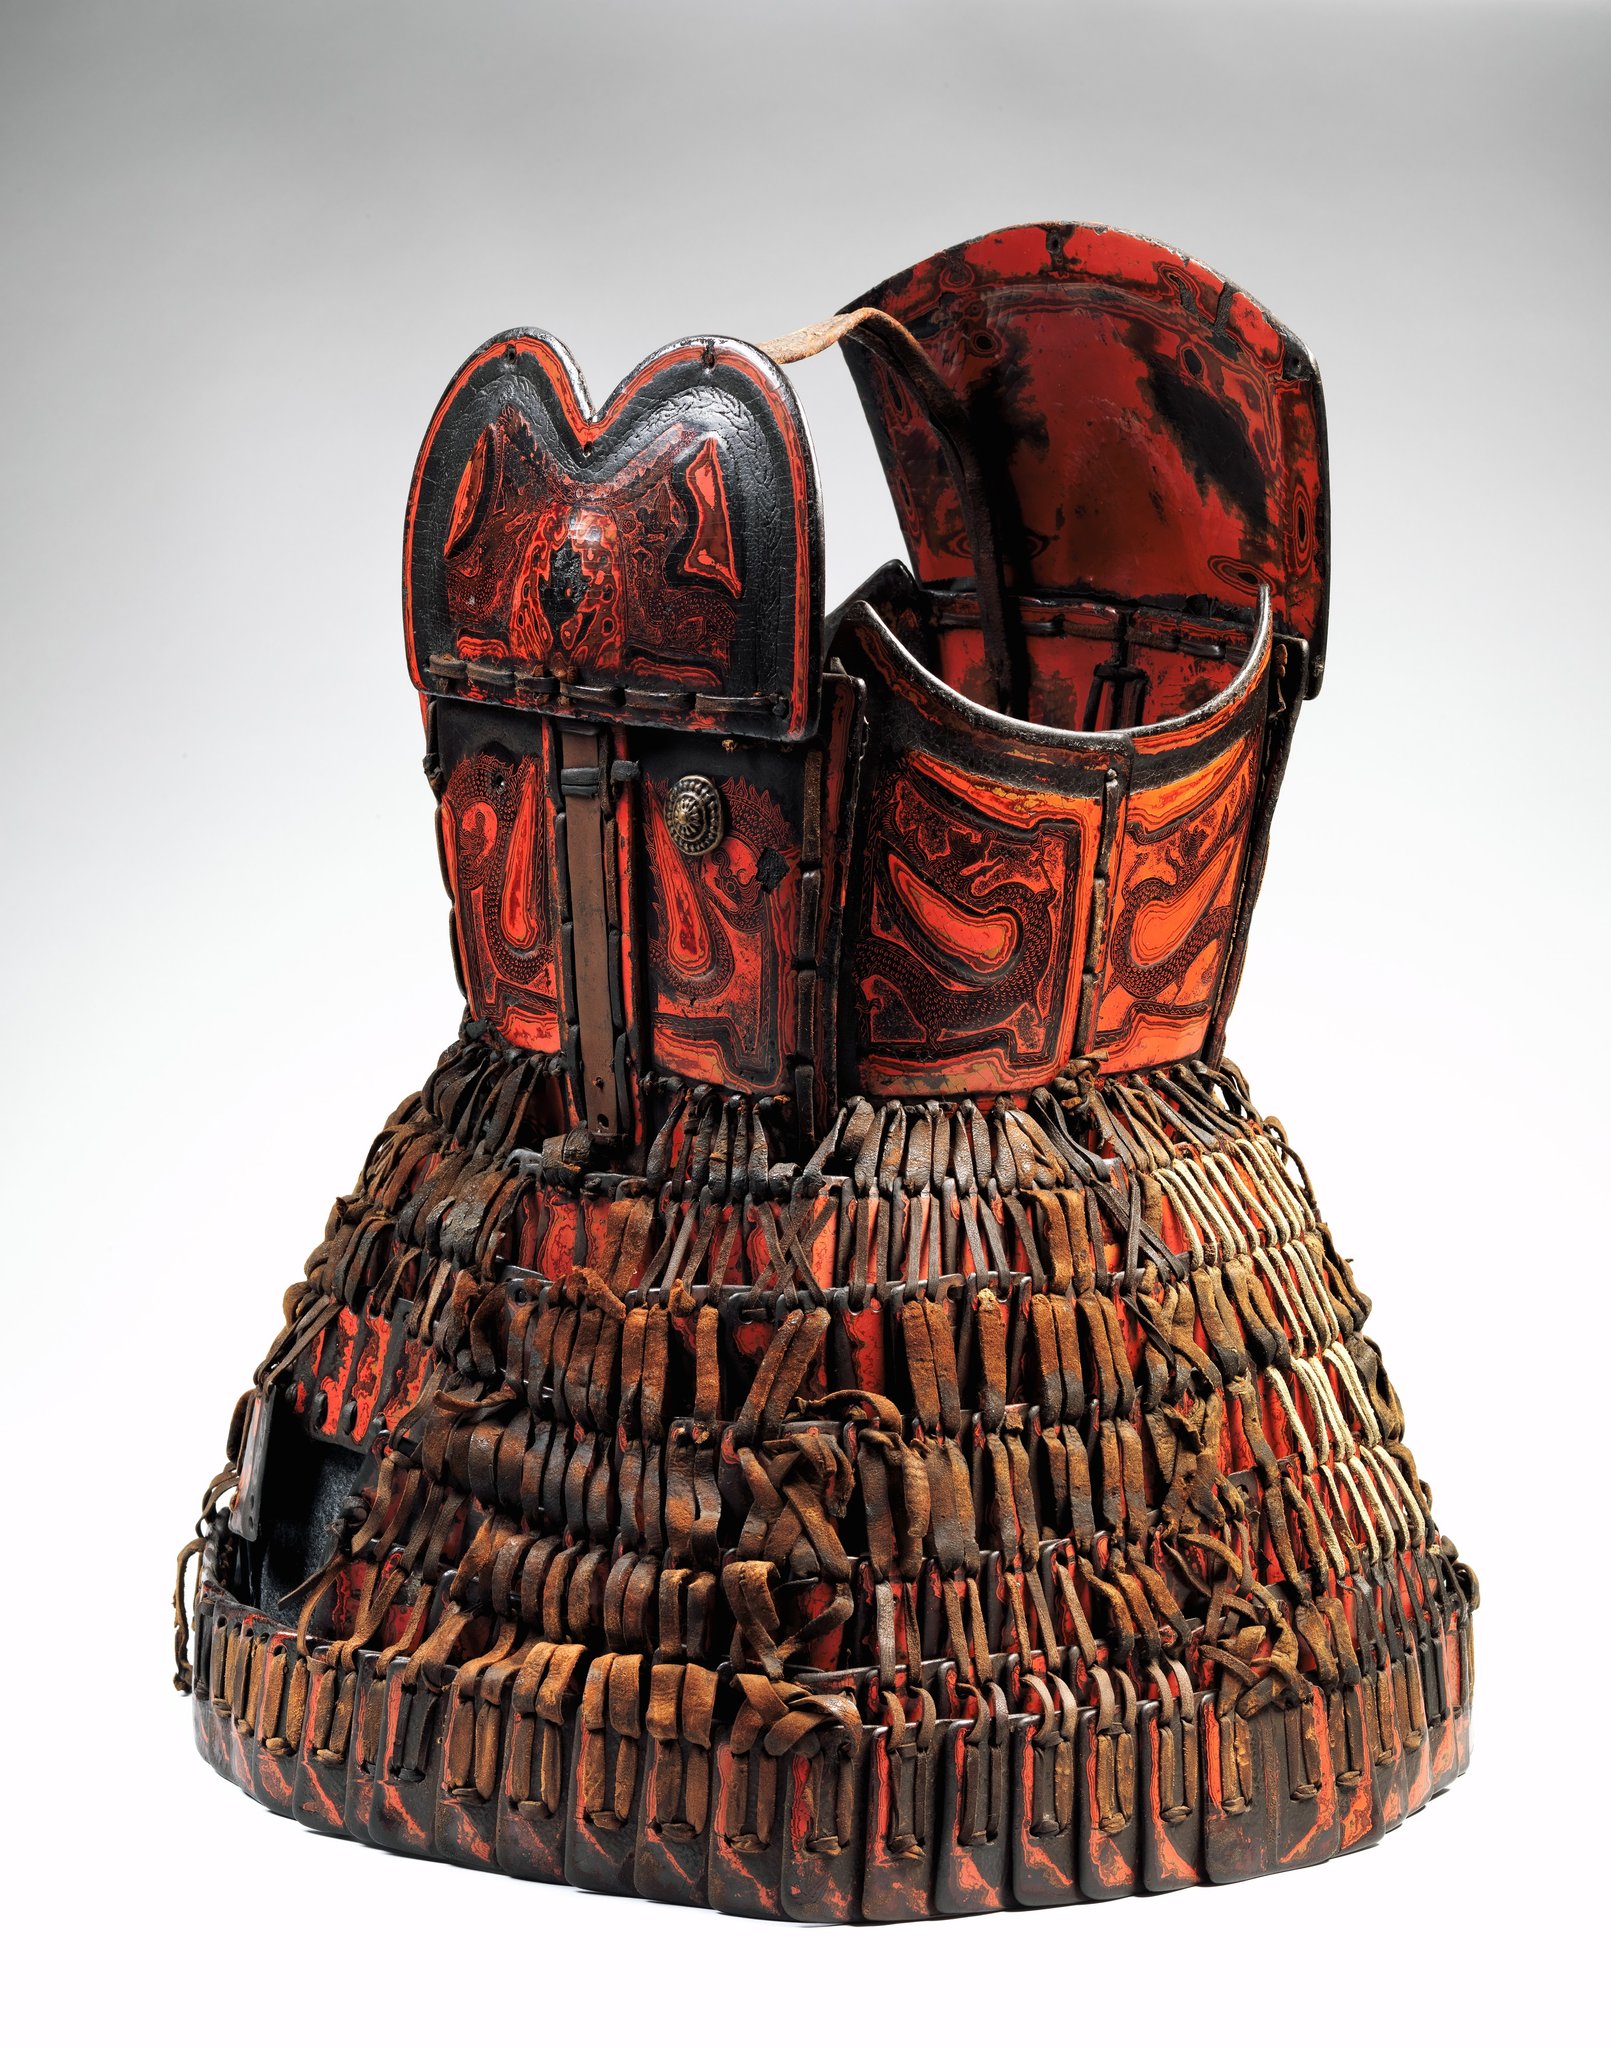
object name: armor for the torso and hip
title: Armor for the Torso and Hips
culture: dali kingdom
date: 1101-1300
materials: copper alloy, iron, lacquer, leather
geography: china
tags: dragons